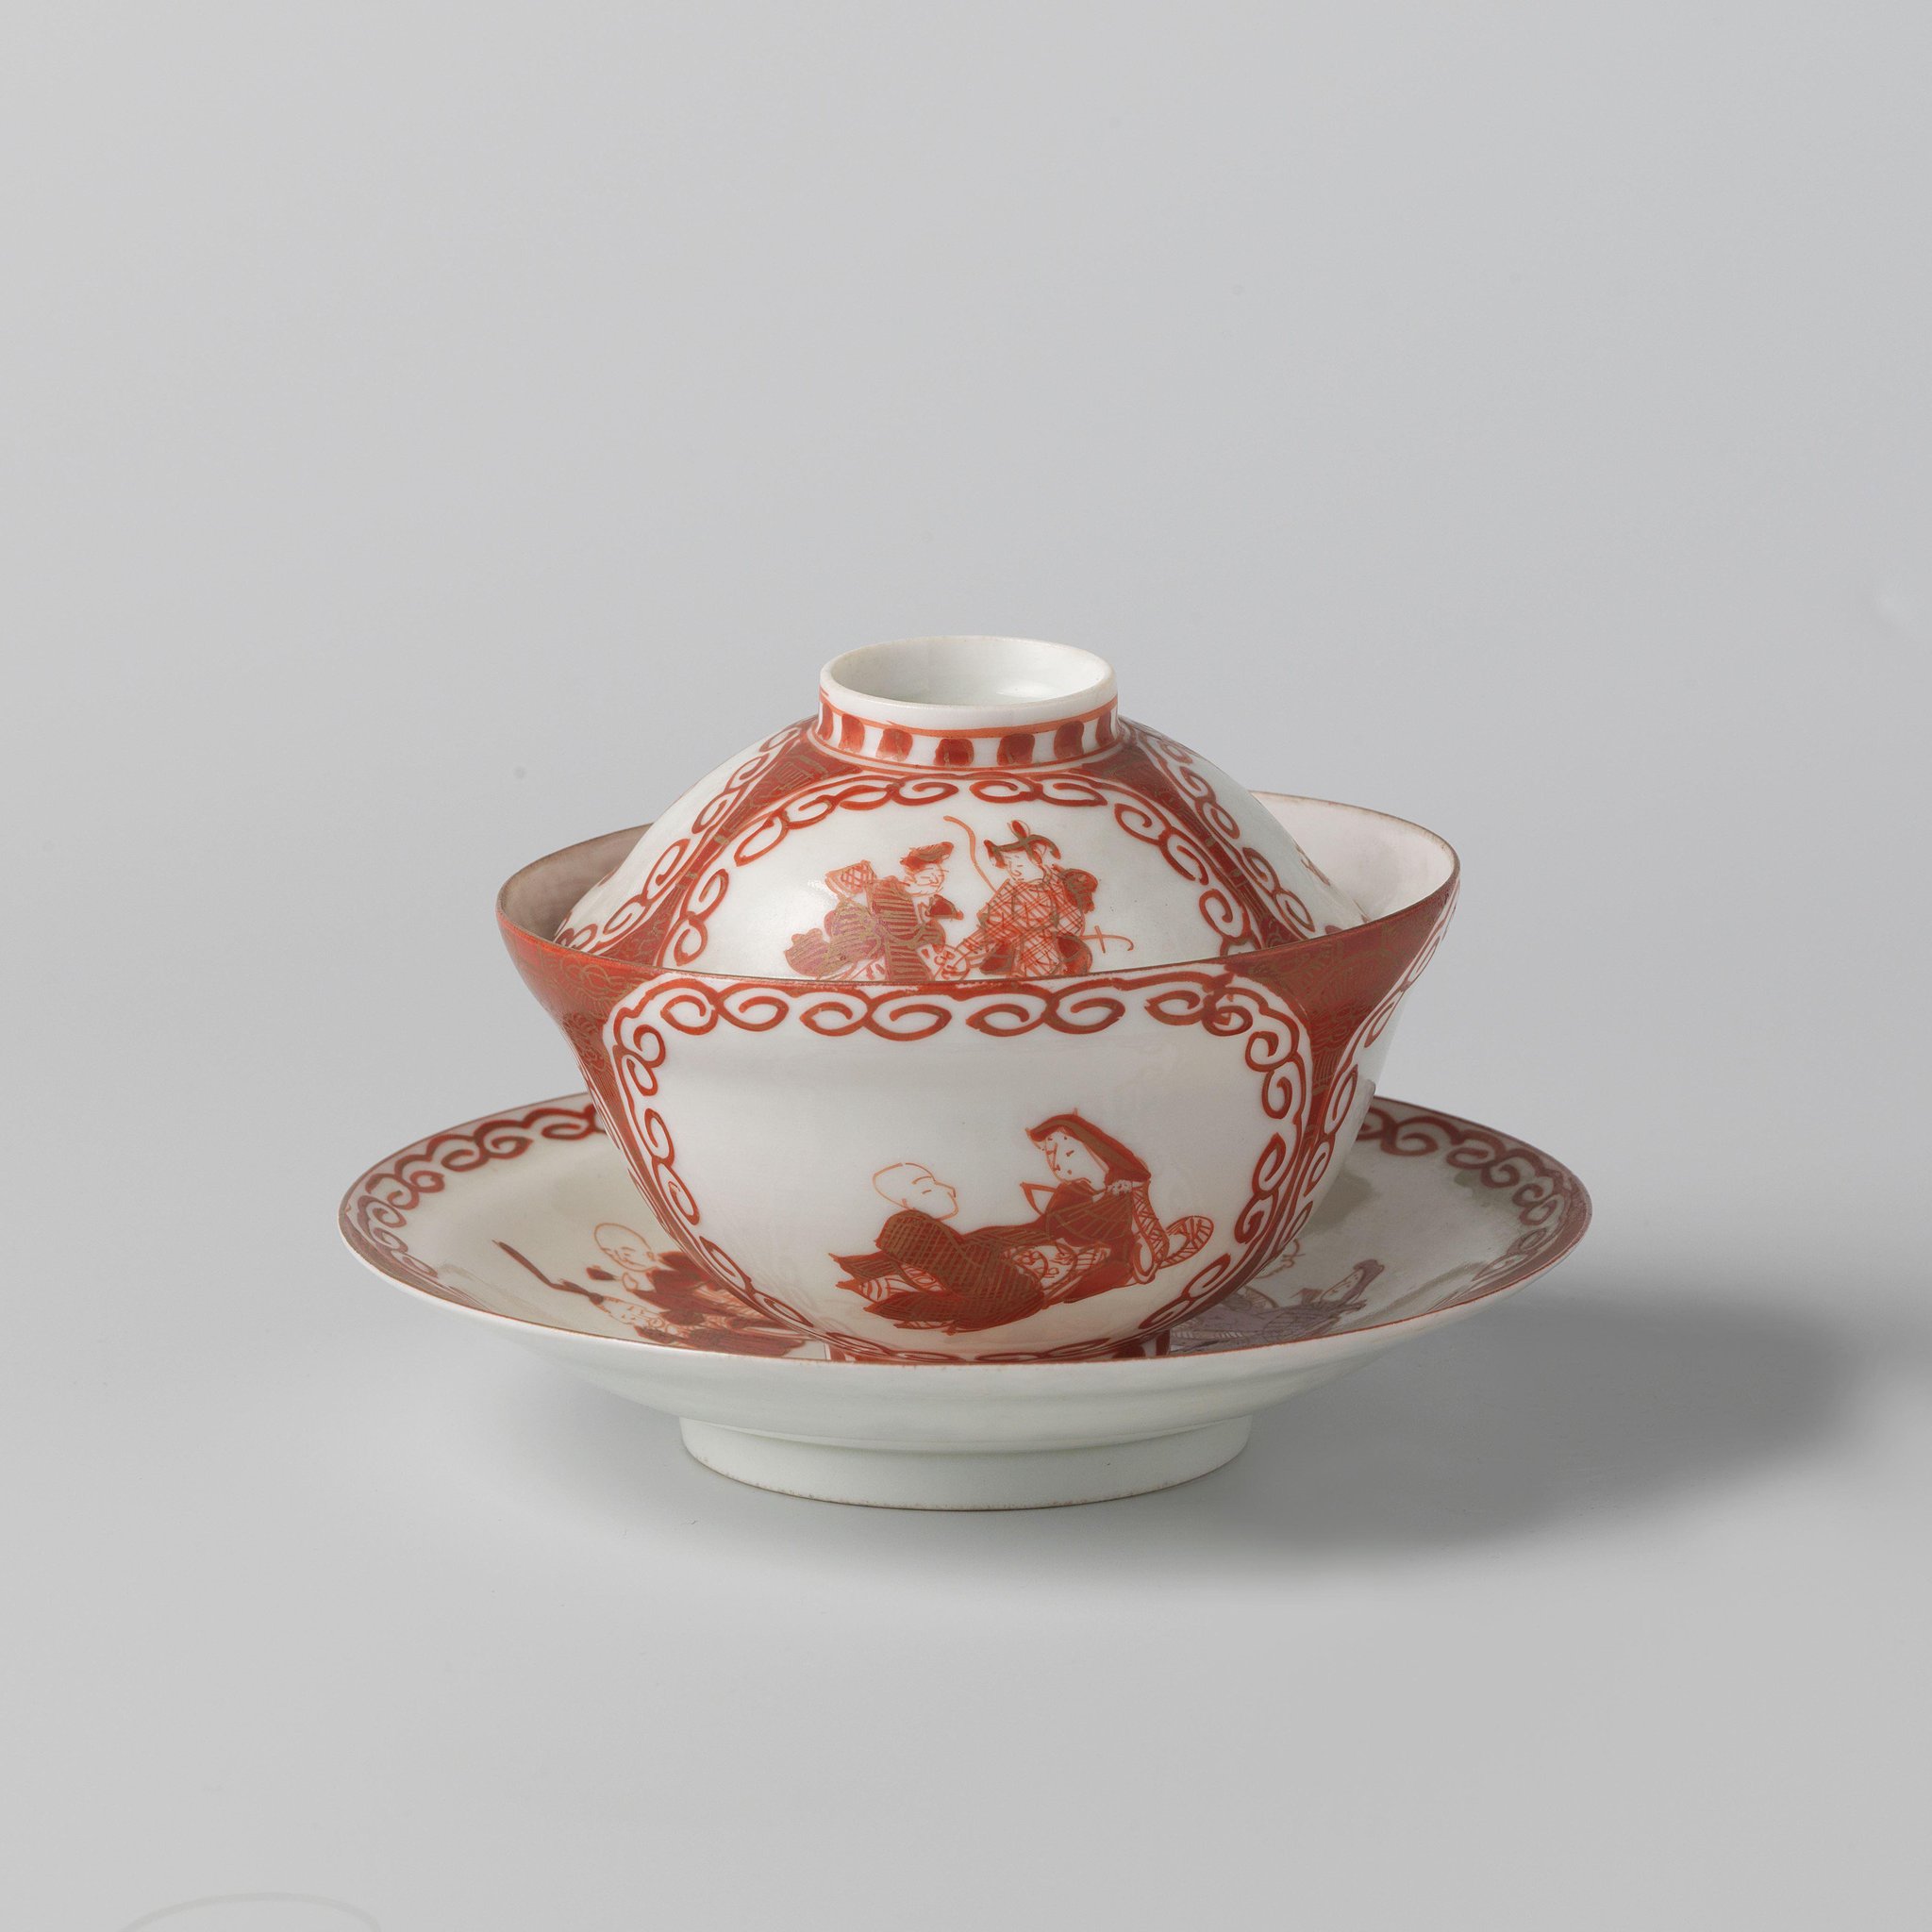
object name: lid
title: Covered cup and saucer with three panels with two seated figures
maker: Anonymous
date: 1800-1899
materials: glaze, gold, paint, porcelain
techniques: firing, gilding, turning, vitrification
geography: japan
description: Deksel van porselein met een ringvormige knop, beschilderd op het glazuur in rood en goud. Op de voorzijde van de deksel drie cartouches met telkens twee zittende mensen omgeven door een band krulwerk; tussen de cartouches een geometrisch patroon. Gemerkt op de onderzijde met drie ongeïdentificeerde karakters. Een chip in de rand van de deksel.